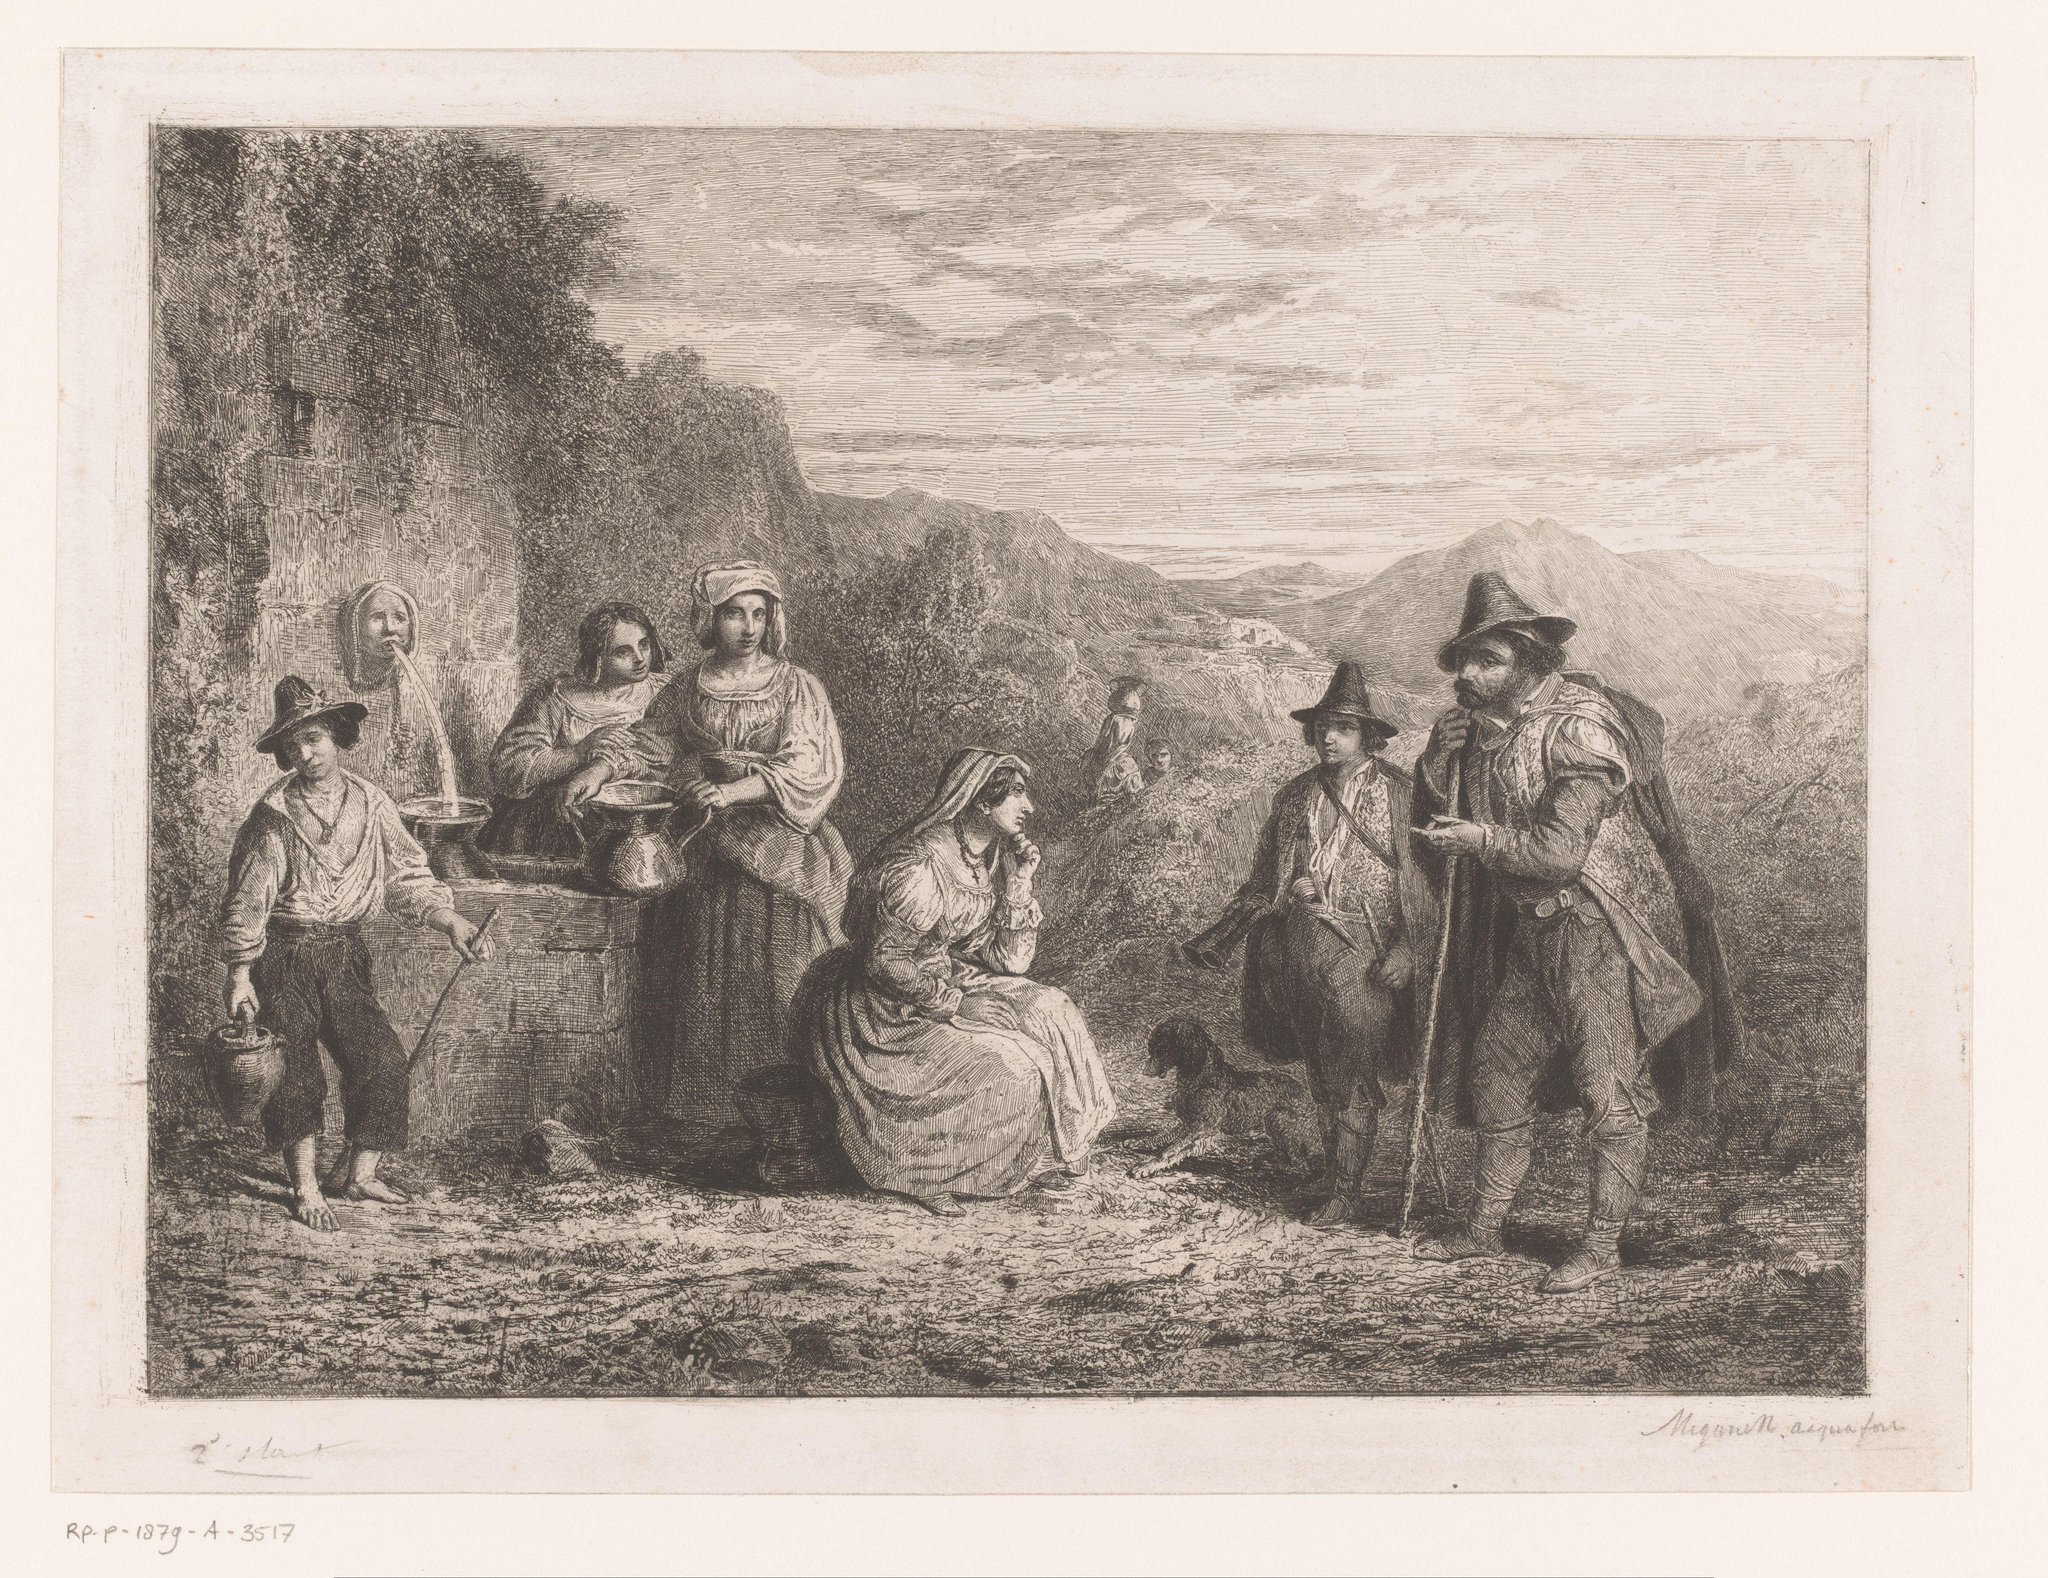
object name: print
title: Reizende muzikanten bij een waterbron in het landschap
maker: joseph meganck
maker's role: print maker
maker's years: 1807-1891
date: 1871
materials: paper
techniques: etching, intaglio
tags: musician - cc - out of doors, ornamental fountain, landscapes (+ landscape with figures, staffage)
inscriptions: collector's mark: Lugt 2228, inscription: ‘2e etat / Meganck aquafort’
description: Waarschijnlijk gaat het om zogeheten 'pifferari'. Dit zijn Italiaanse herders uit Campanië die naar Rome reizen om voor Mariabeelden te musiceren.